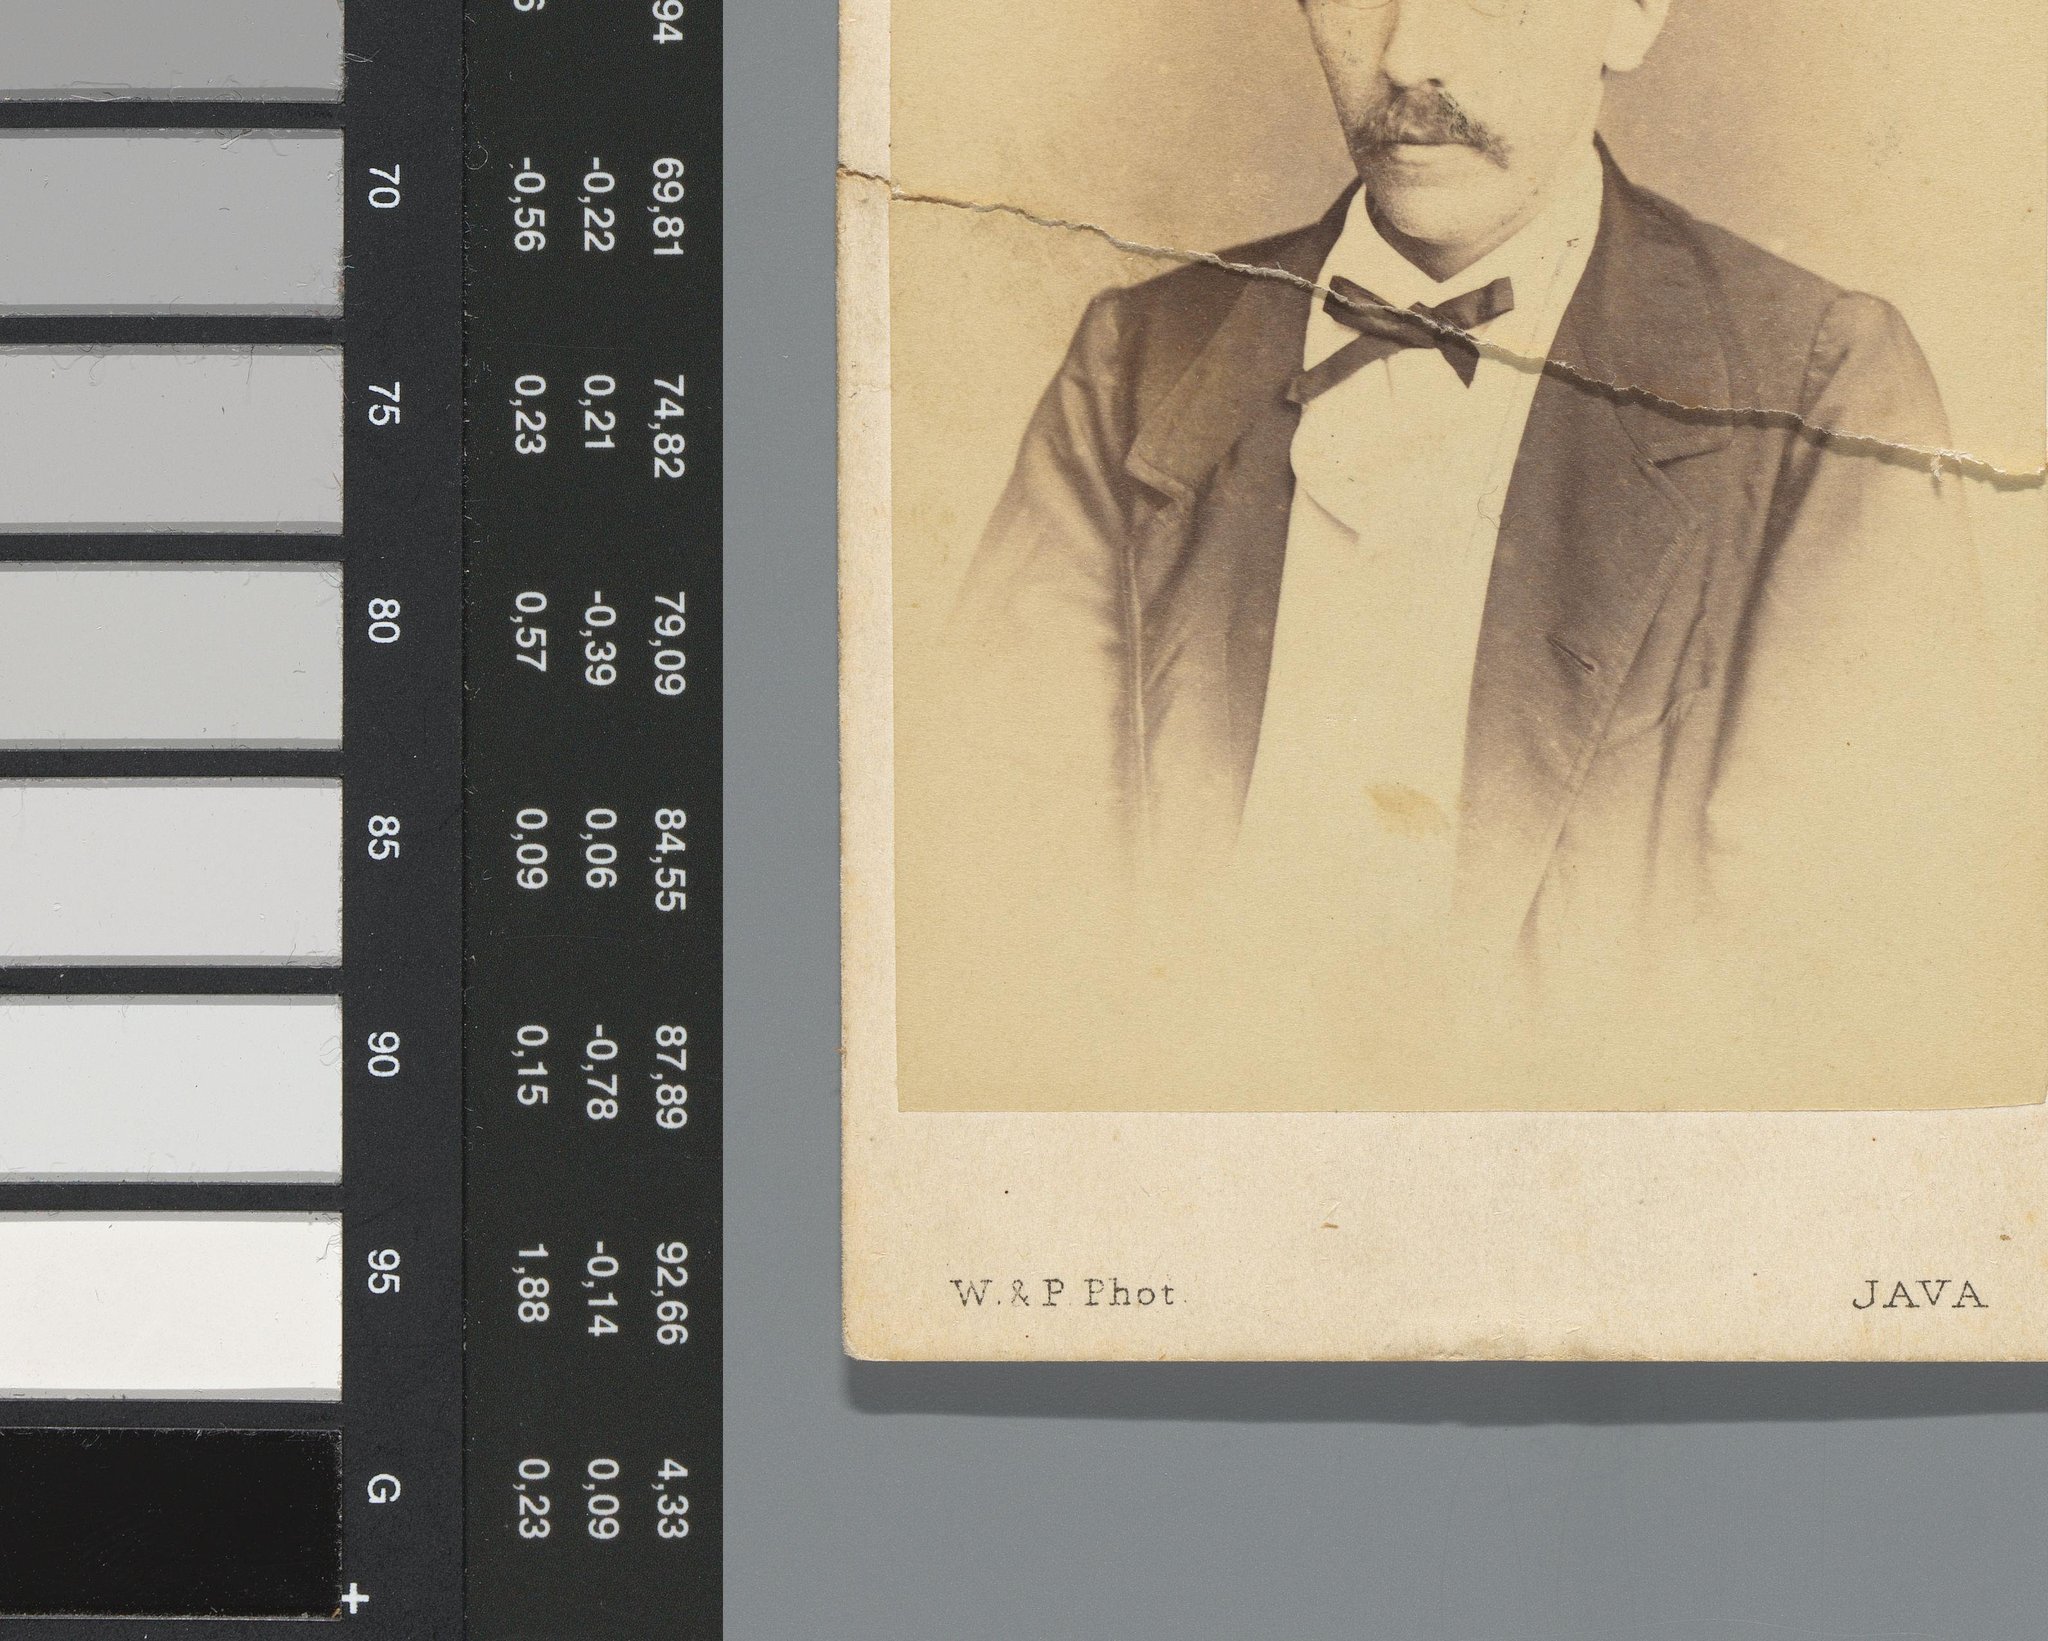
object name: carte de visite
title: Portret van Norbert van den Berg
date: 1855-1910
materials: cardboard, photographic support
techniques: albumen print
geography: java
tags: norbertus petrus van den berg (1831-1917)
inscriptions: name: ‘W.&P. Phot. Java’